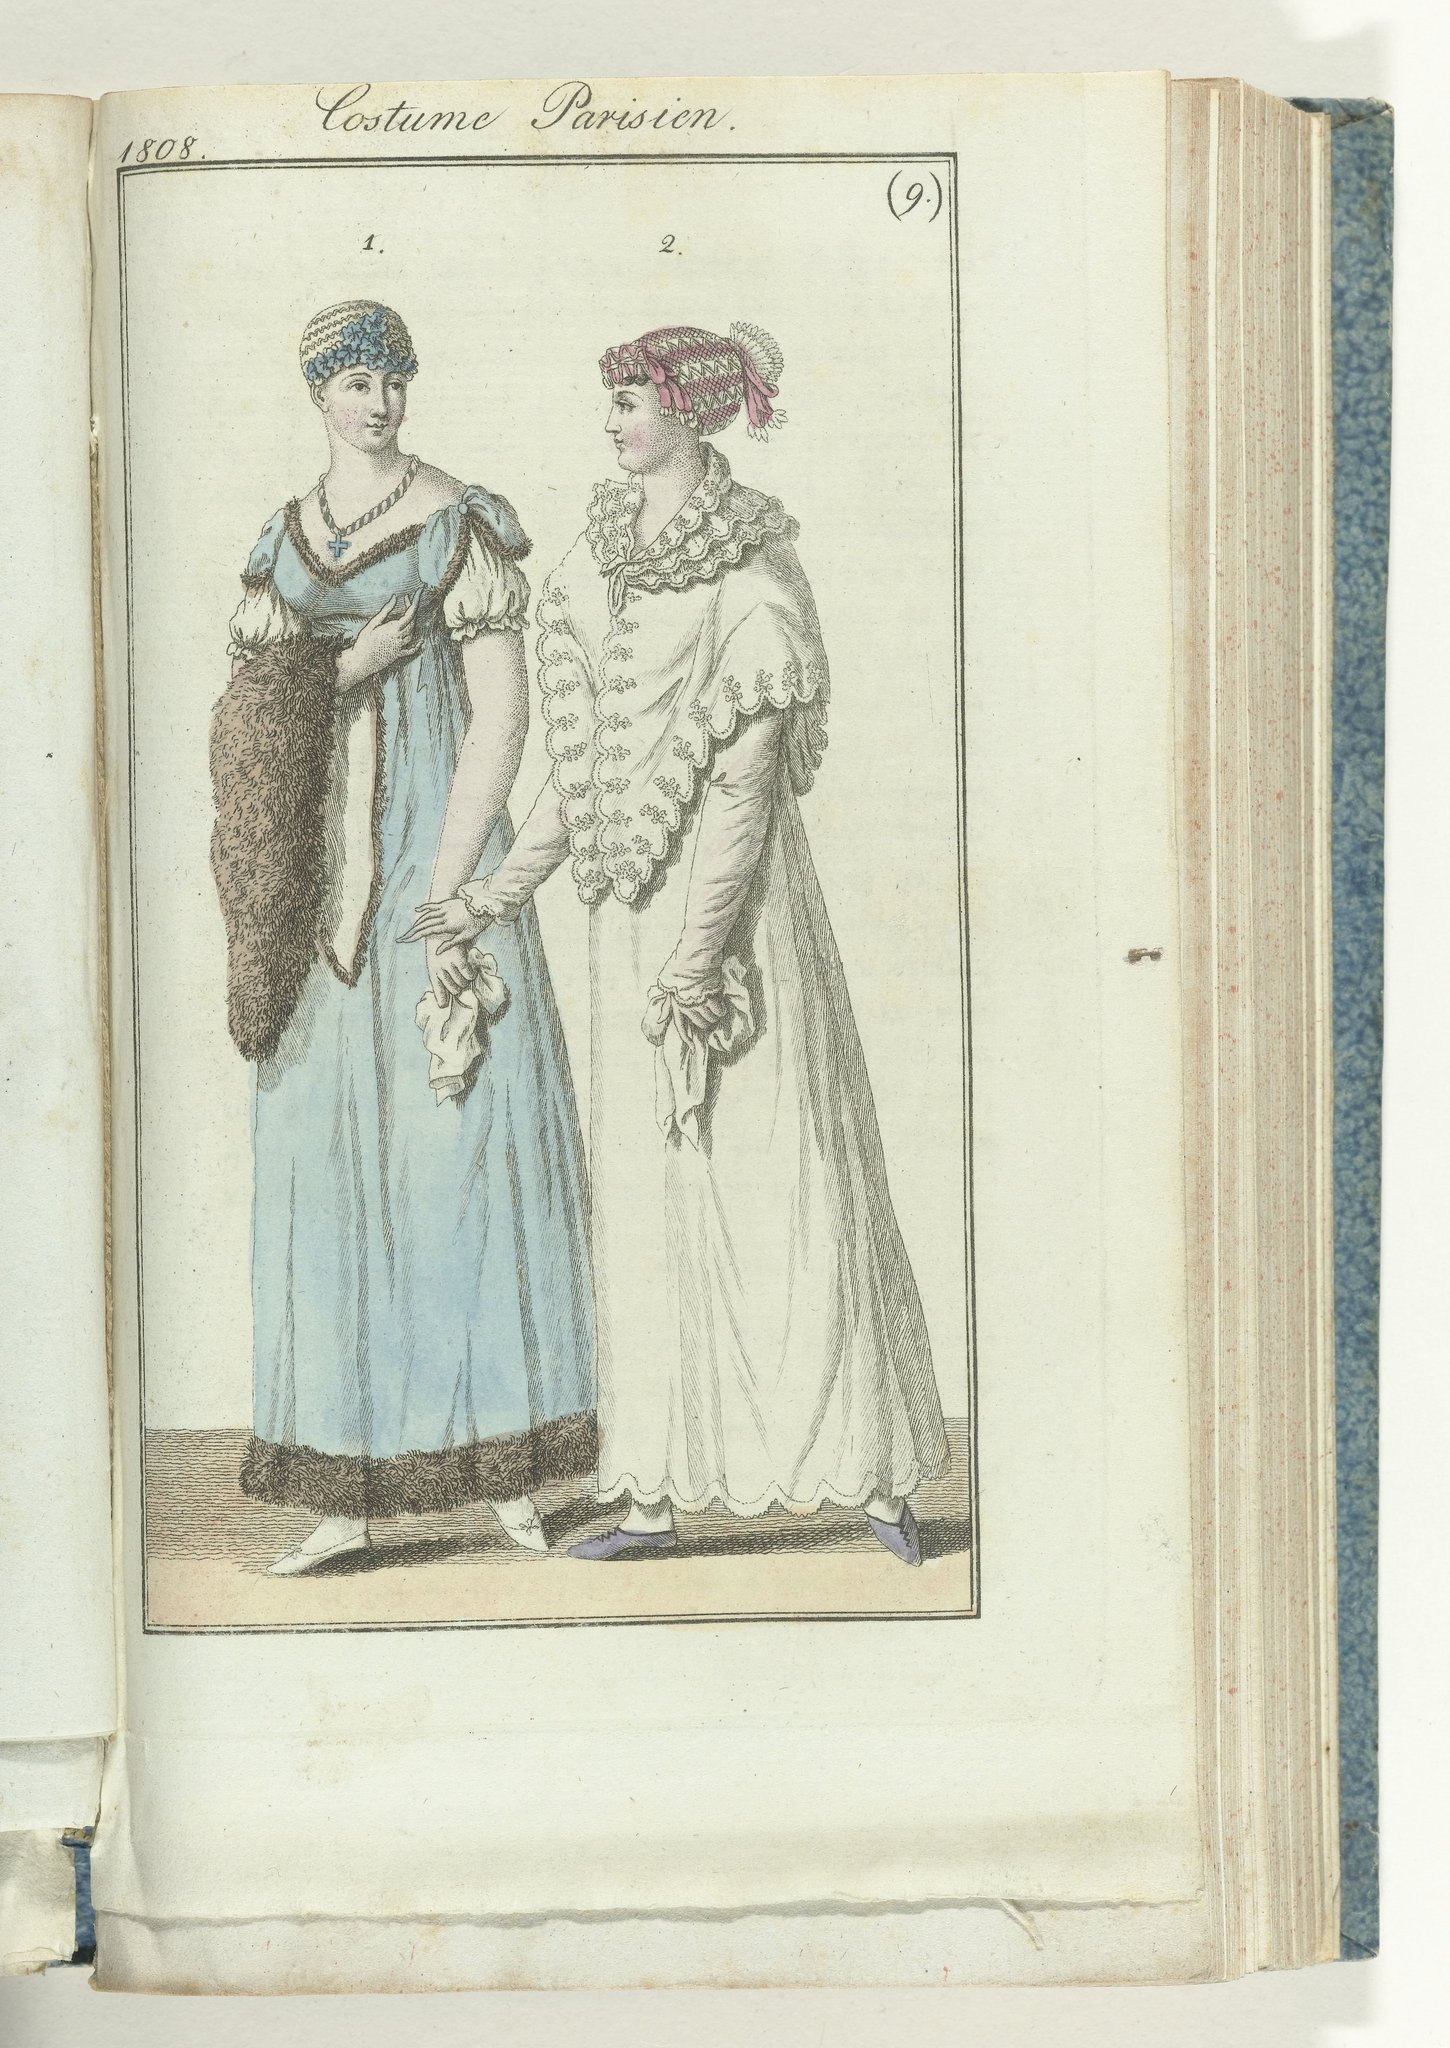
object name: fashion print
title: Journal des Dames et des Modes, editie Frankfurt 29 Février 1808, Costume Parisien (9)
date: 1808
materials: paper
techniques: engraving, hand coloring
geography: frankfurt am main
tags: pendant, trinket, 'breloque' (+ women's clothes), handkerchief (+ women's clothes), border, ribbon, braid (+ fur used for clothes), neck-gear ~ clothing (palatine) (+ women's clothes), neck-gear ~ clothing (palatine) (+ feathers used for clothes), head-gear (+ women's clothes), styles of hairdress - aa - ~ women, fashion plates, dress, gown (+ women's clothes), piece of clothing covering the breast or décolleté (fichu) (+ women's clothes)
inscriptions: title: ‘Costume Parisien.’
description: De begeleidende tekst (p. 237-238) vermeldt: Fig. 1: Coiffure formée d'un filet et d'une touffe de rubans. Collier met kruisje. Japon van hemelsblauwe zijde, laag uitgesneden en afgezet met bont. Korte pofmouwen. Witte schoenen. (bontje over de arm) Fig. 2: Coiffure met haarnetje van zijde en wol. Robe courte van witte mousseline, met geschulpte onderrand. Geborduurd fichu met omgeslagen kraagje et a double garniture Violetkleurige schoenen. De prent maakt deel uit van het modetijdschrift Journal des Dames et des Modes, uitgegeven in Frankfurt als kopie van de Franse editie van Pierre de la Mésangère, (1798-1848).